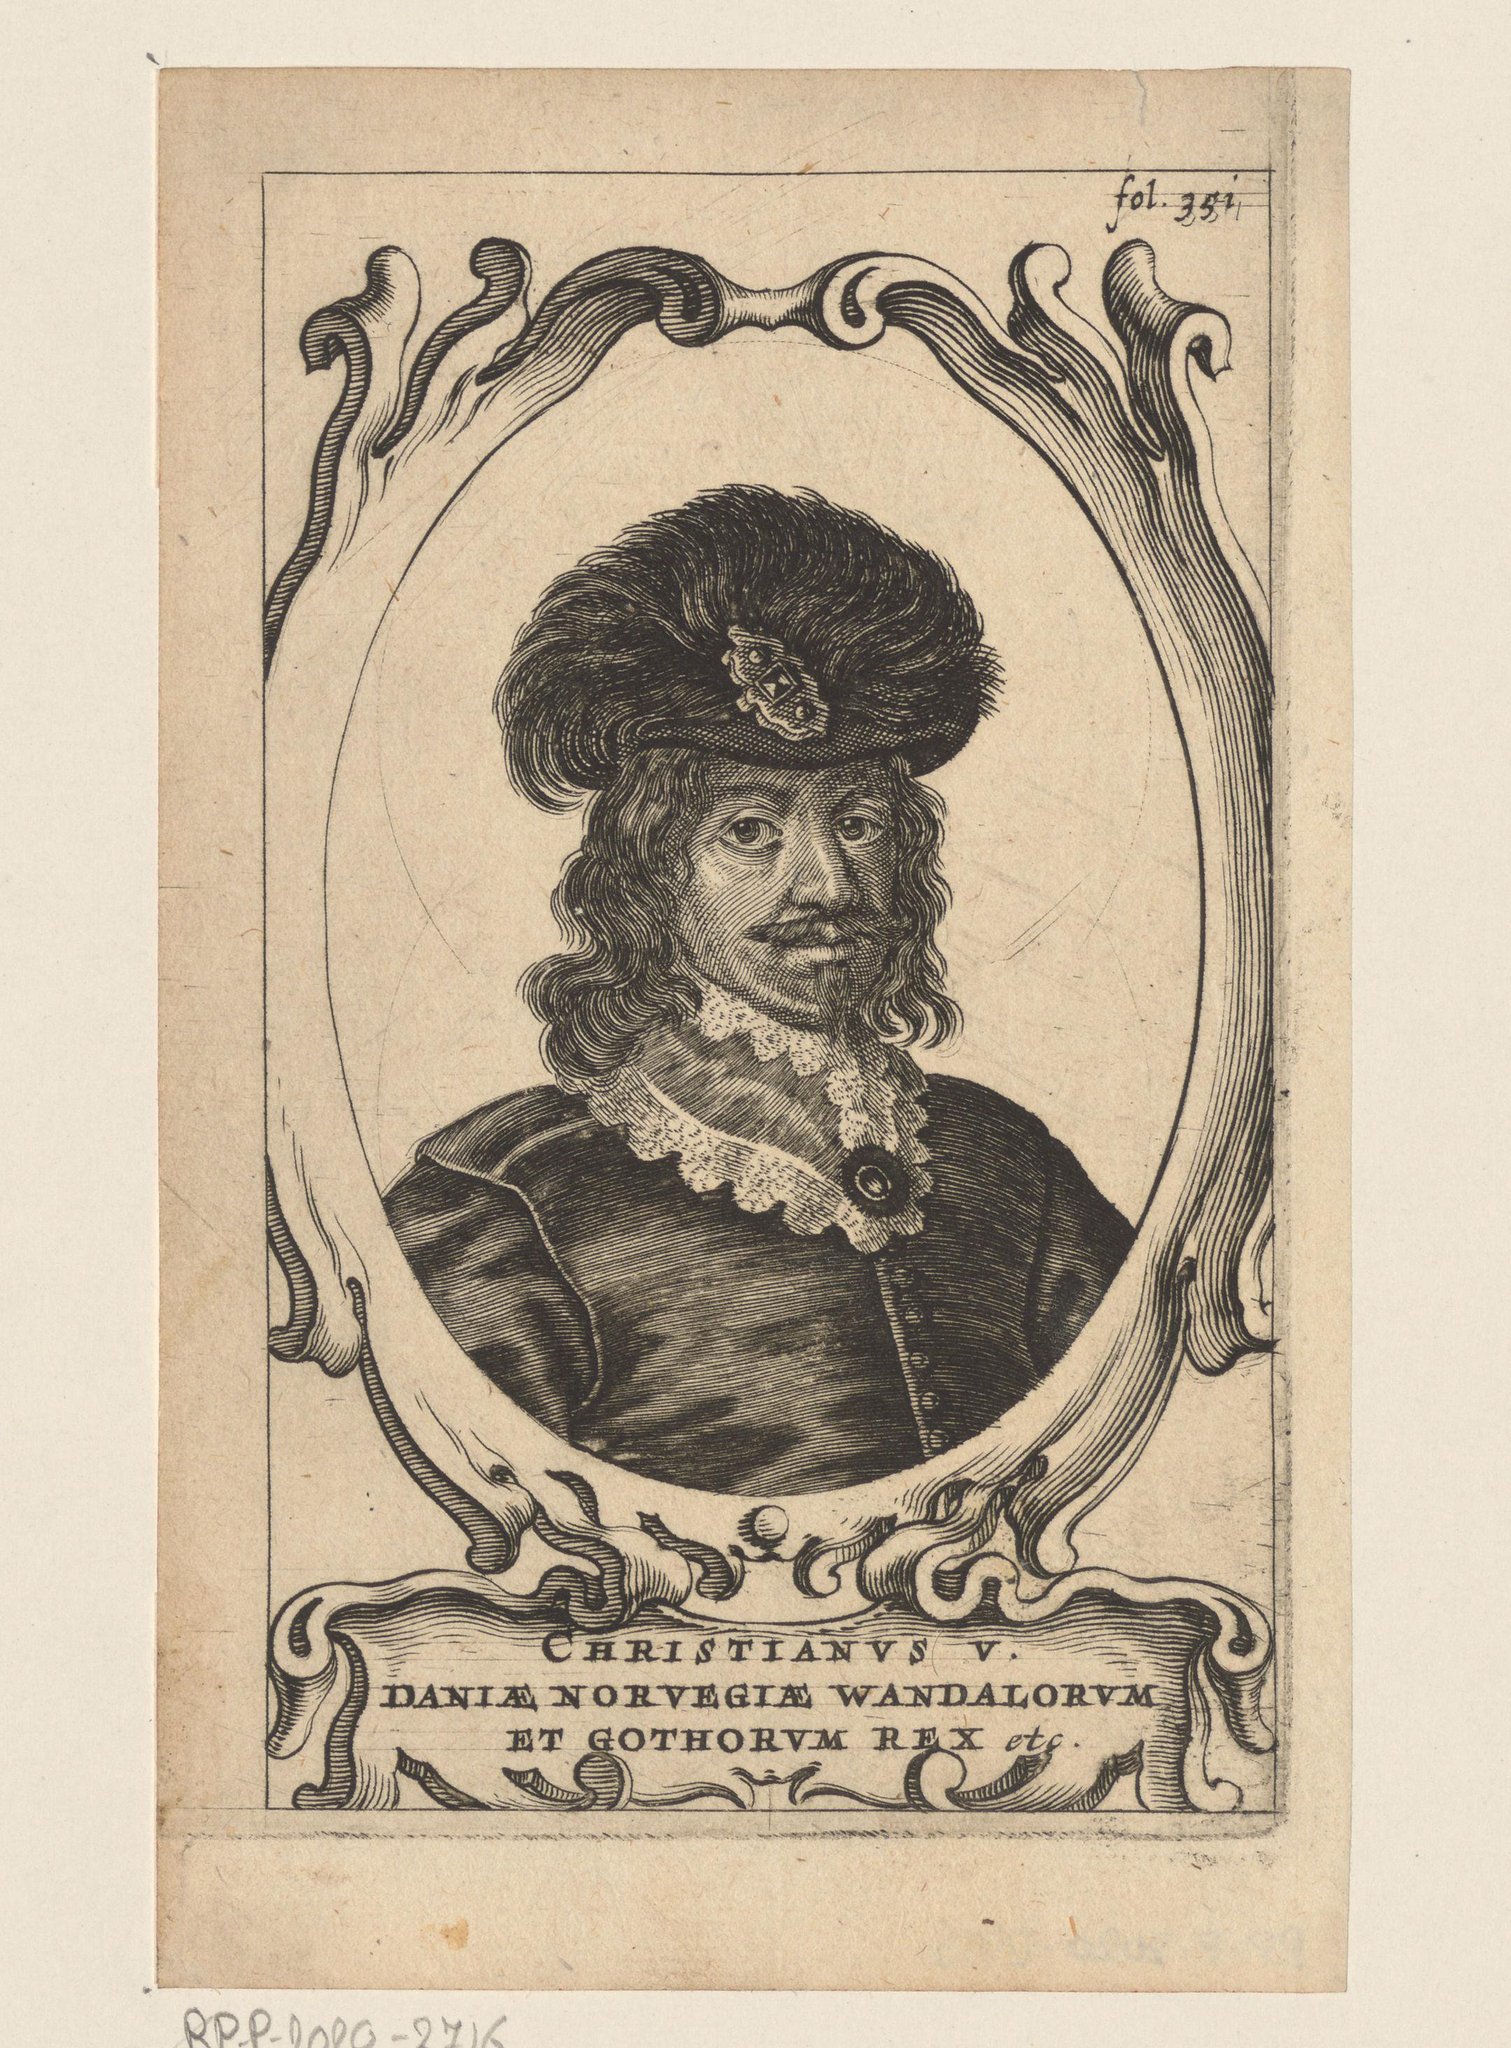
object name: print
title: Portret van Christiaan V, koning van Denemarken en Noorwegen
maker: Anonymous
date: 1656-1666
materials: paper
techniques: engraving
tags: copenhagen (city), historical persons, king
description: Prent waarschijnlijk uit: Brachelius, Johannes Adolphus. Historia nostri temporis, dat is geschiedenis onses tijts (…). Rotterdam: Andries van Hoogenhuysen, 1656. Prent ook gebruikt in latere edities (1659, 1666).